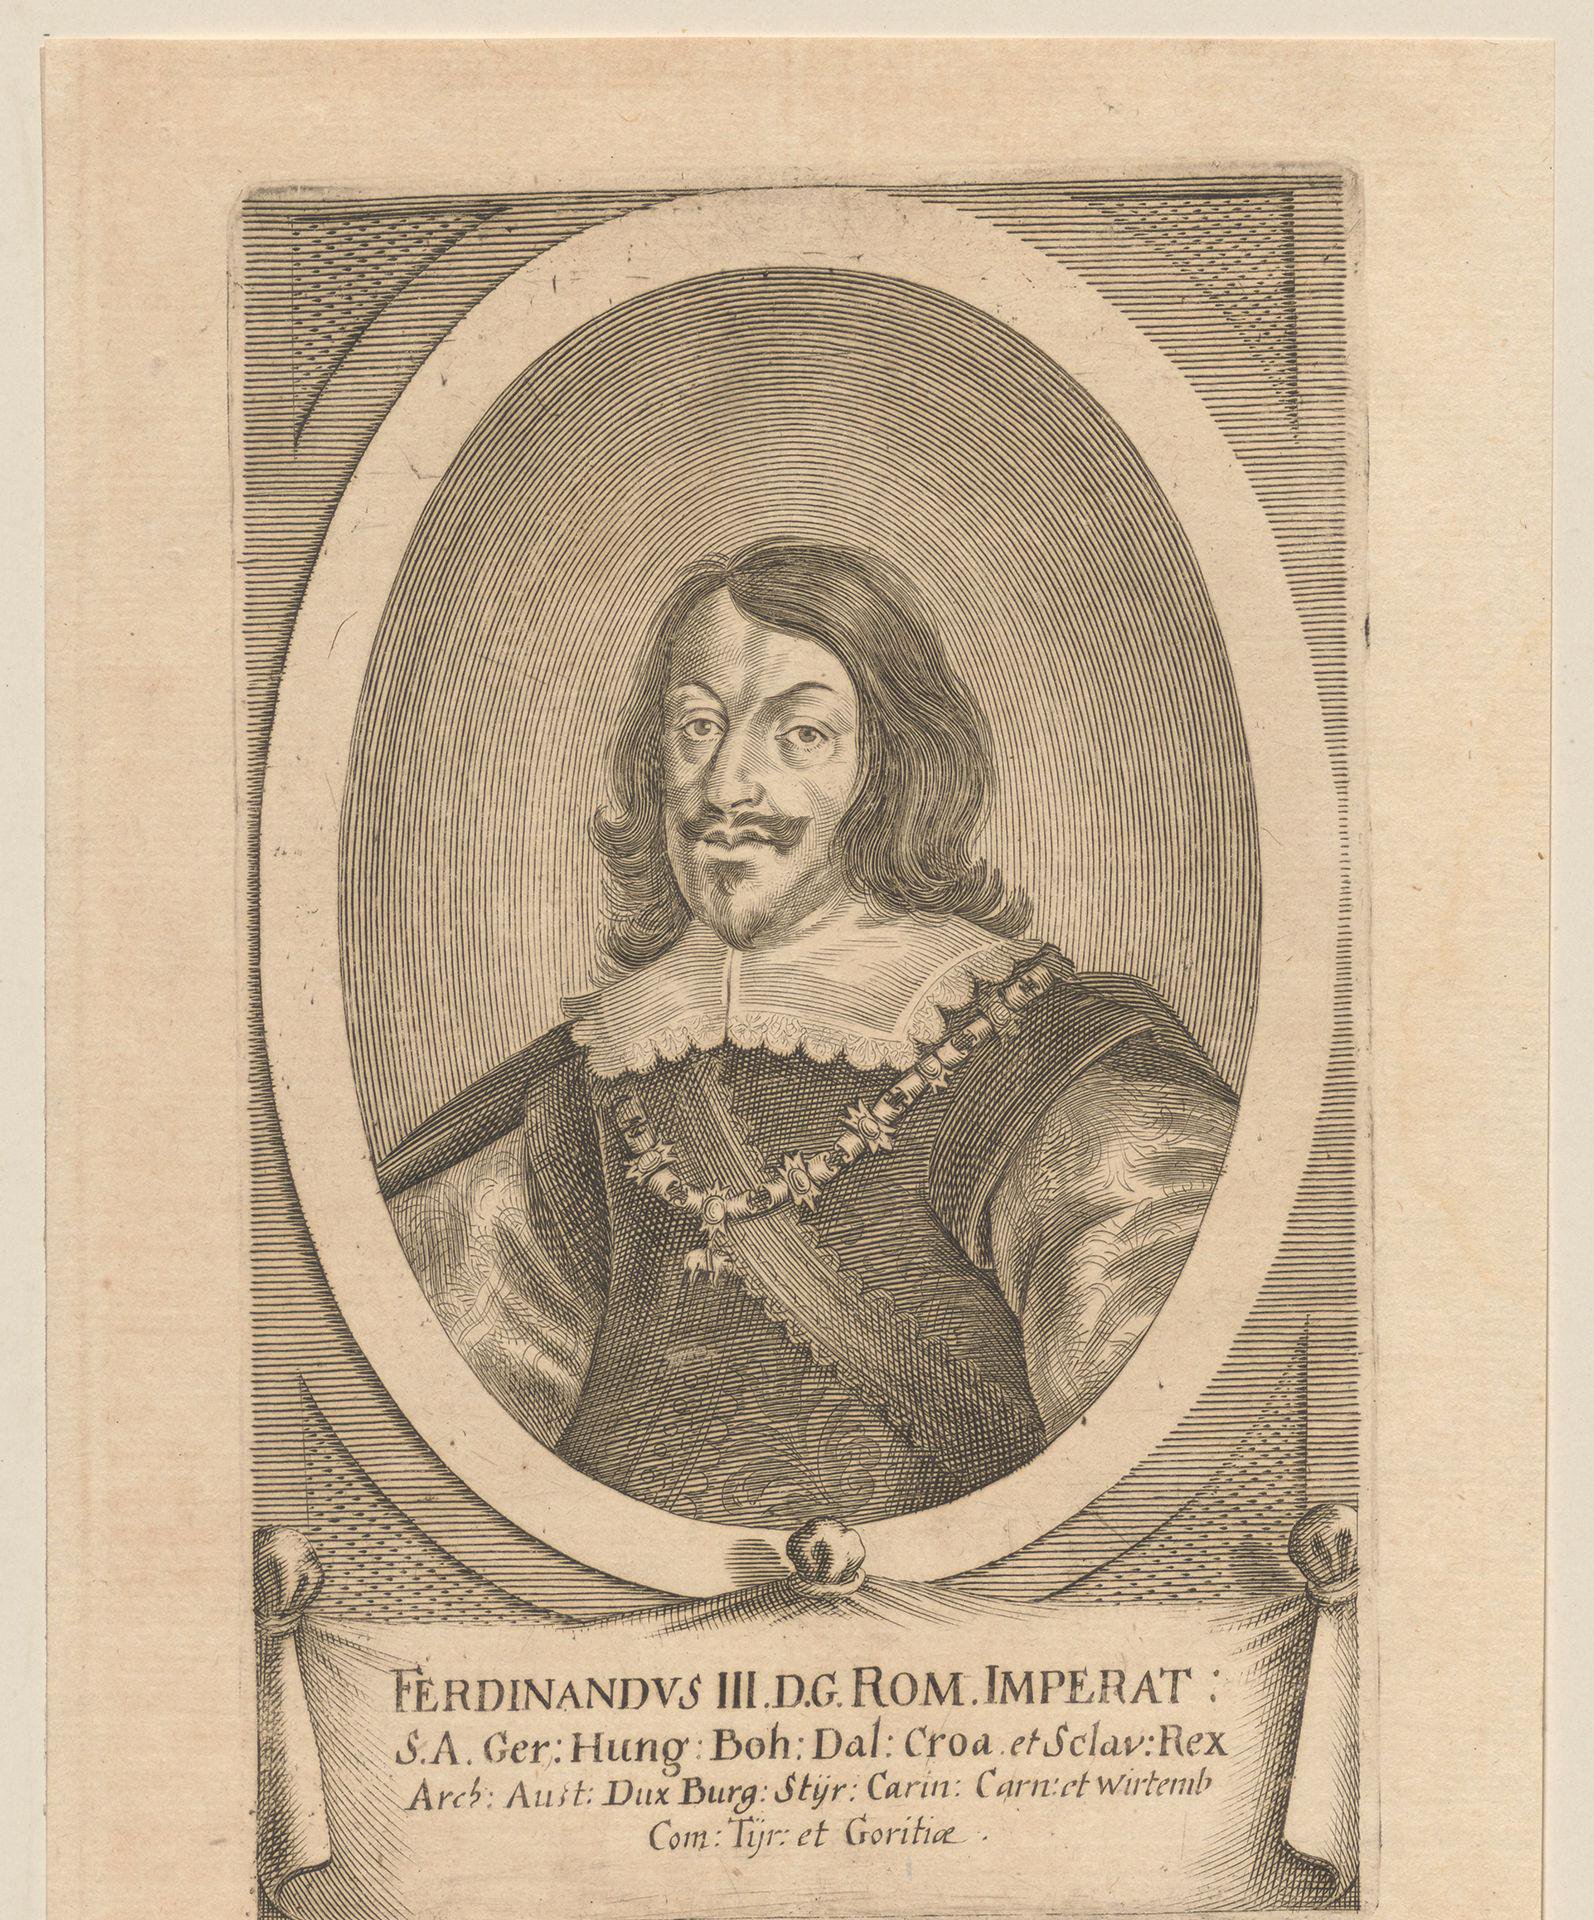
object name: print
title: Portret van keizer Ferdinand III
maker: Anonymous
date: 1637-1700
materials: paper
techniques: engraving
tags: vienna, ferdinand iii (duits keizer), historical persons, knighthood order of the golden fleece, emperor